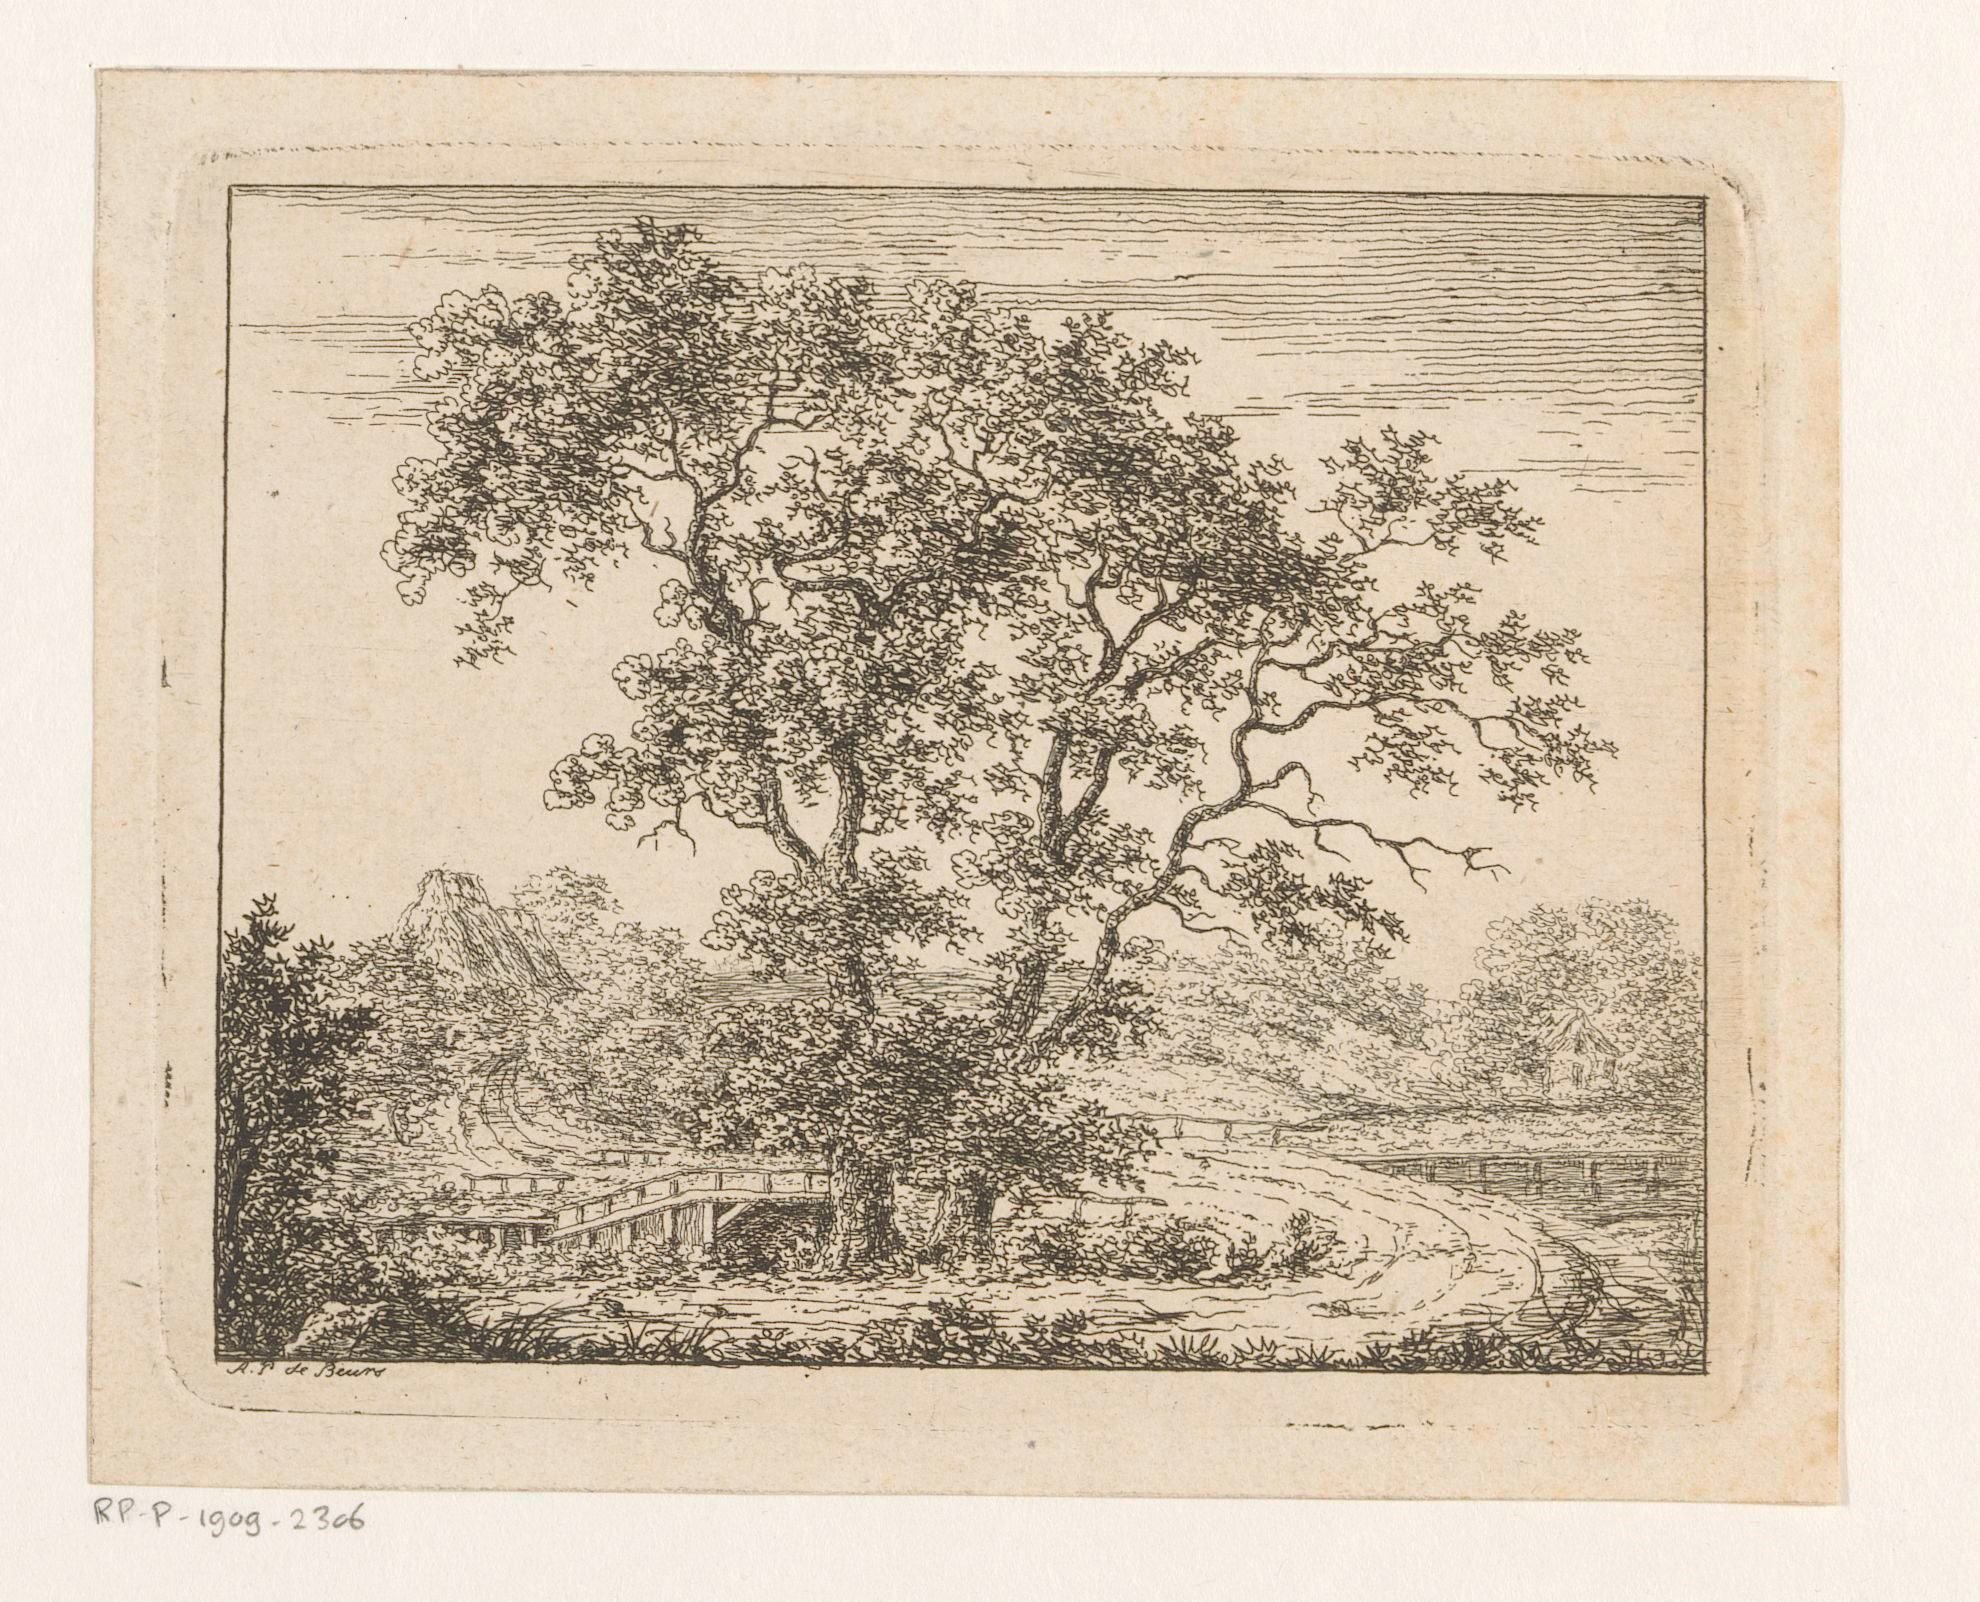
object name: print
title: Landschap met een weg die zich om twee bomen buigt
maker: andré paul de beurs-stiermans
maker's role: print maker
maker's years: 1802-1832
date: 1812-1832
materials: paper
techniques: etching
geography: hamburg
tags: landscapes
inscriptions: collector's mark: Lugt 2228